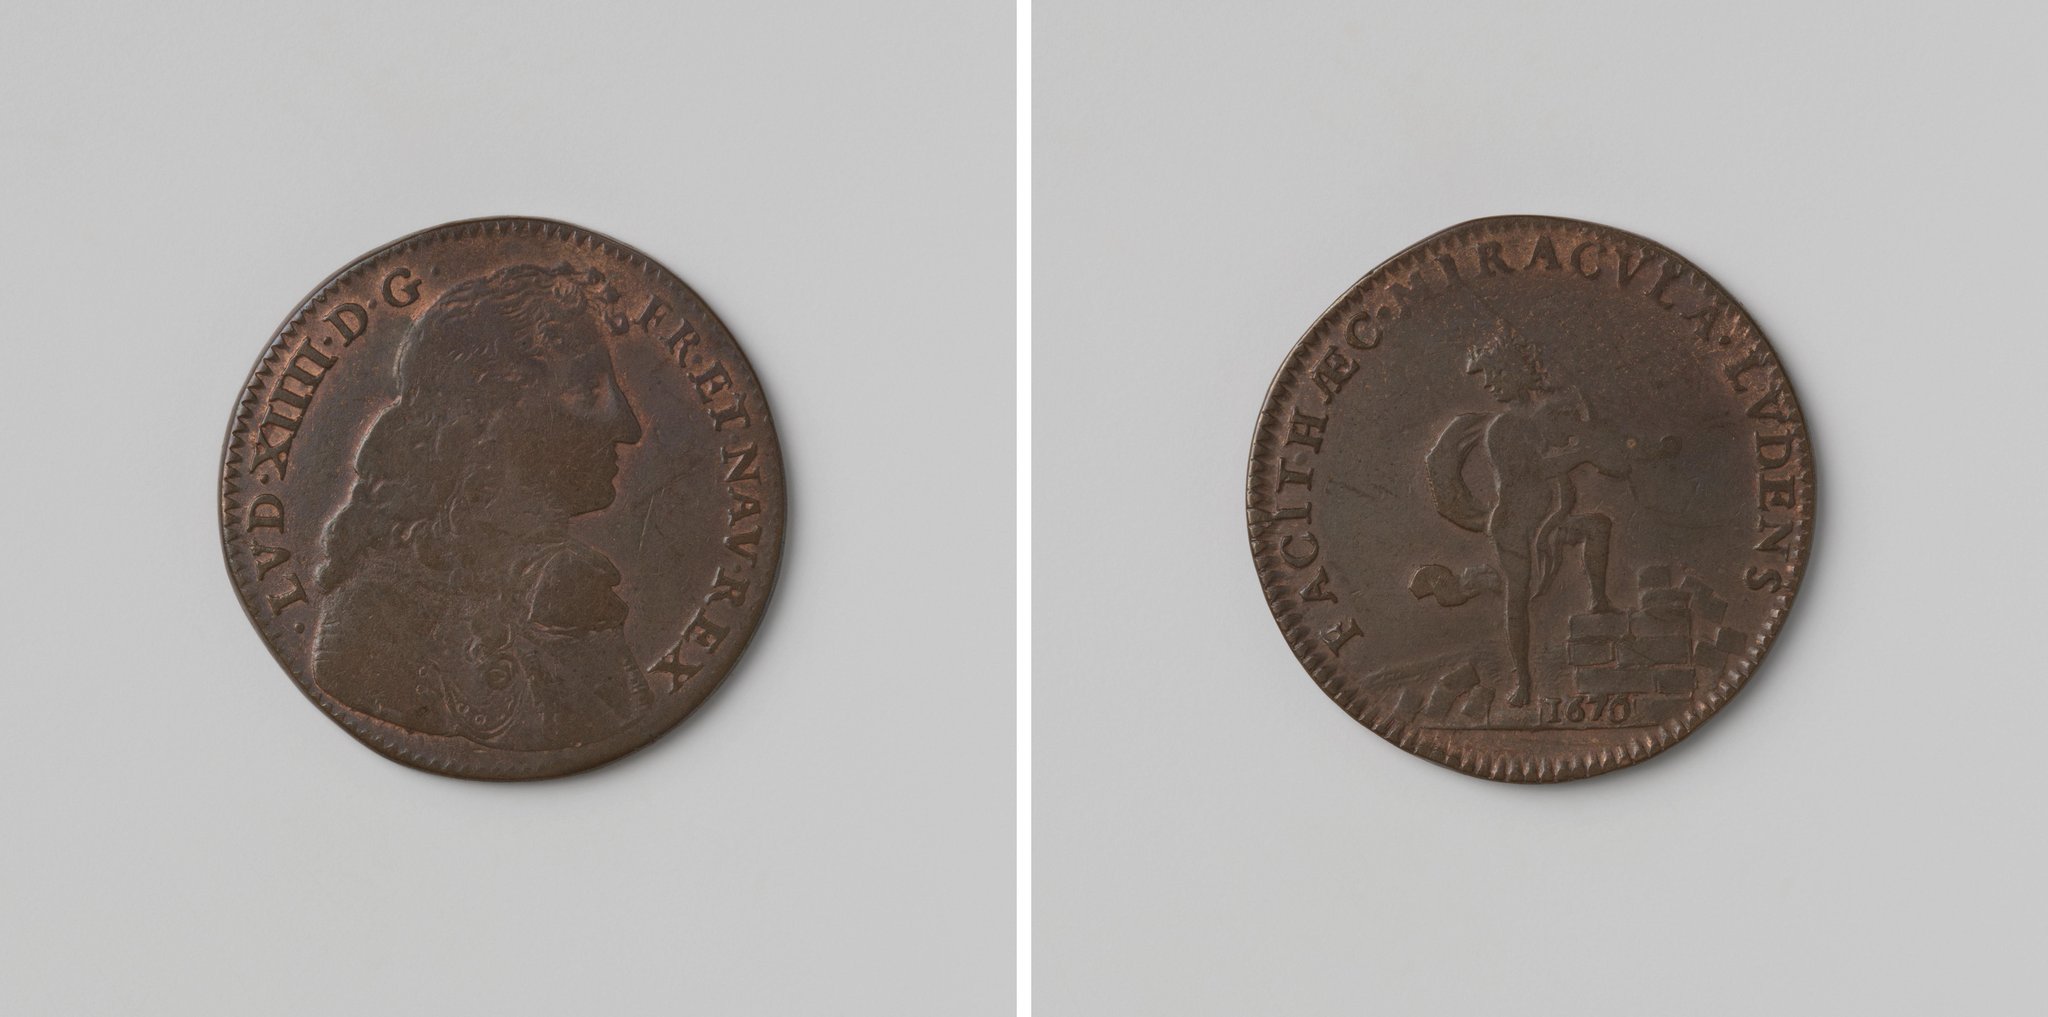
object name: jeton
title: Grote macht van Lodewijk XIV, koning van Frankrijk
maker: Anonymous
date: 1670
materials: copper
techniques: striking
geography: france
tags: lodewijk xiv (koning van frankrijk)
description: Koperen penning. Voorzijde: borststuk man binnen omschrift. Keerzijde: Lodewijk, afgebeeld als Amphion, spelend op lier en met voet staande op stapel stenen binnen omschrift